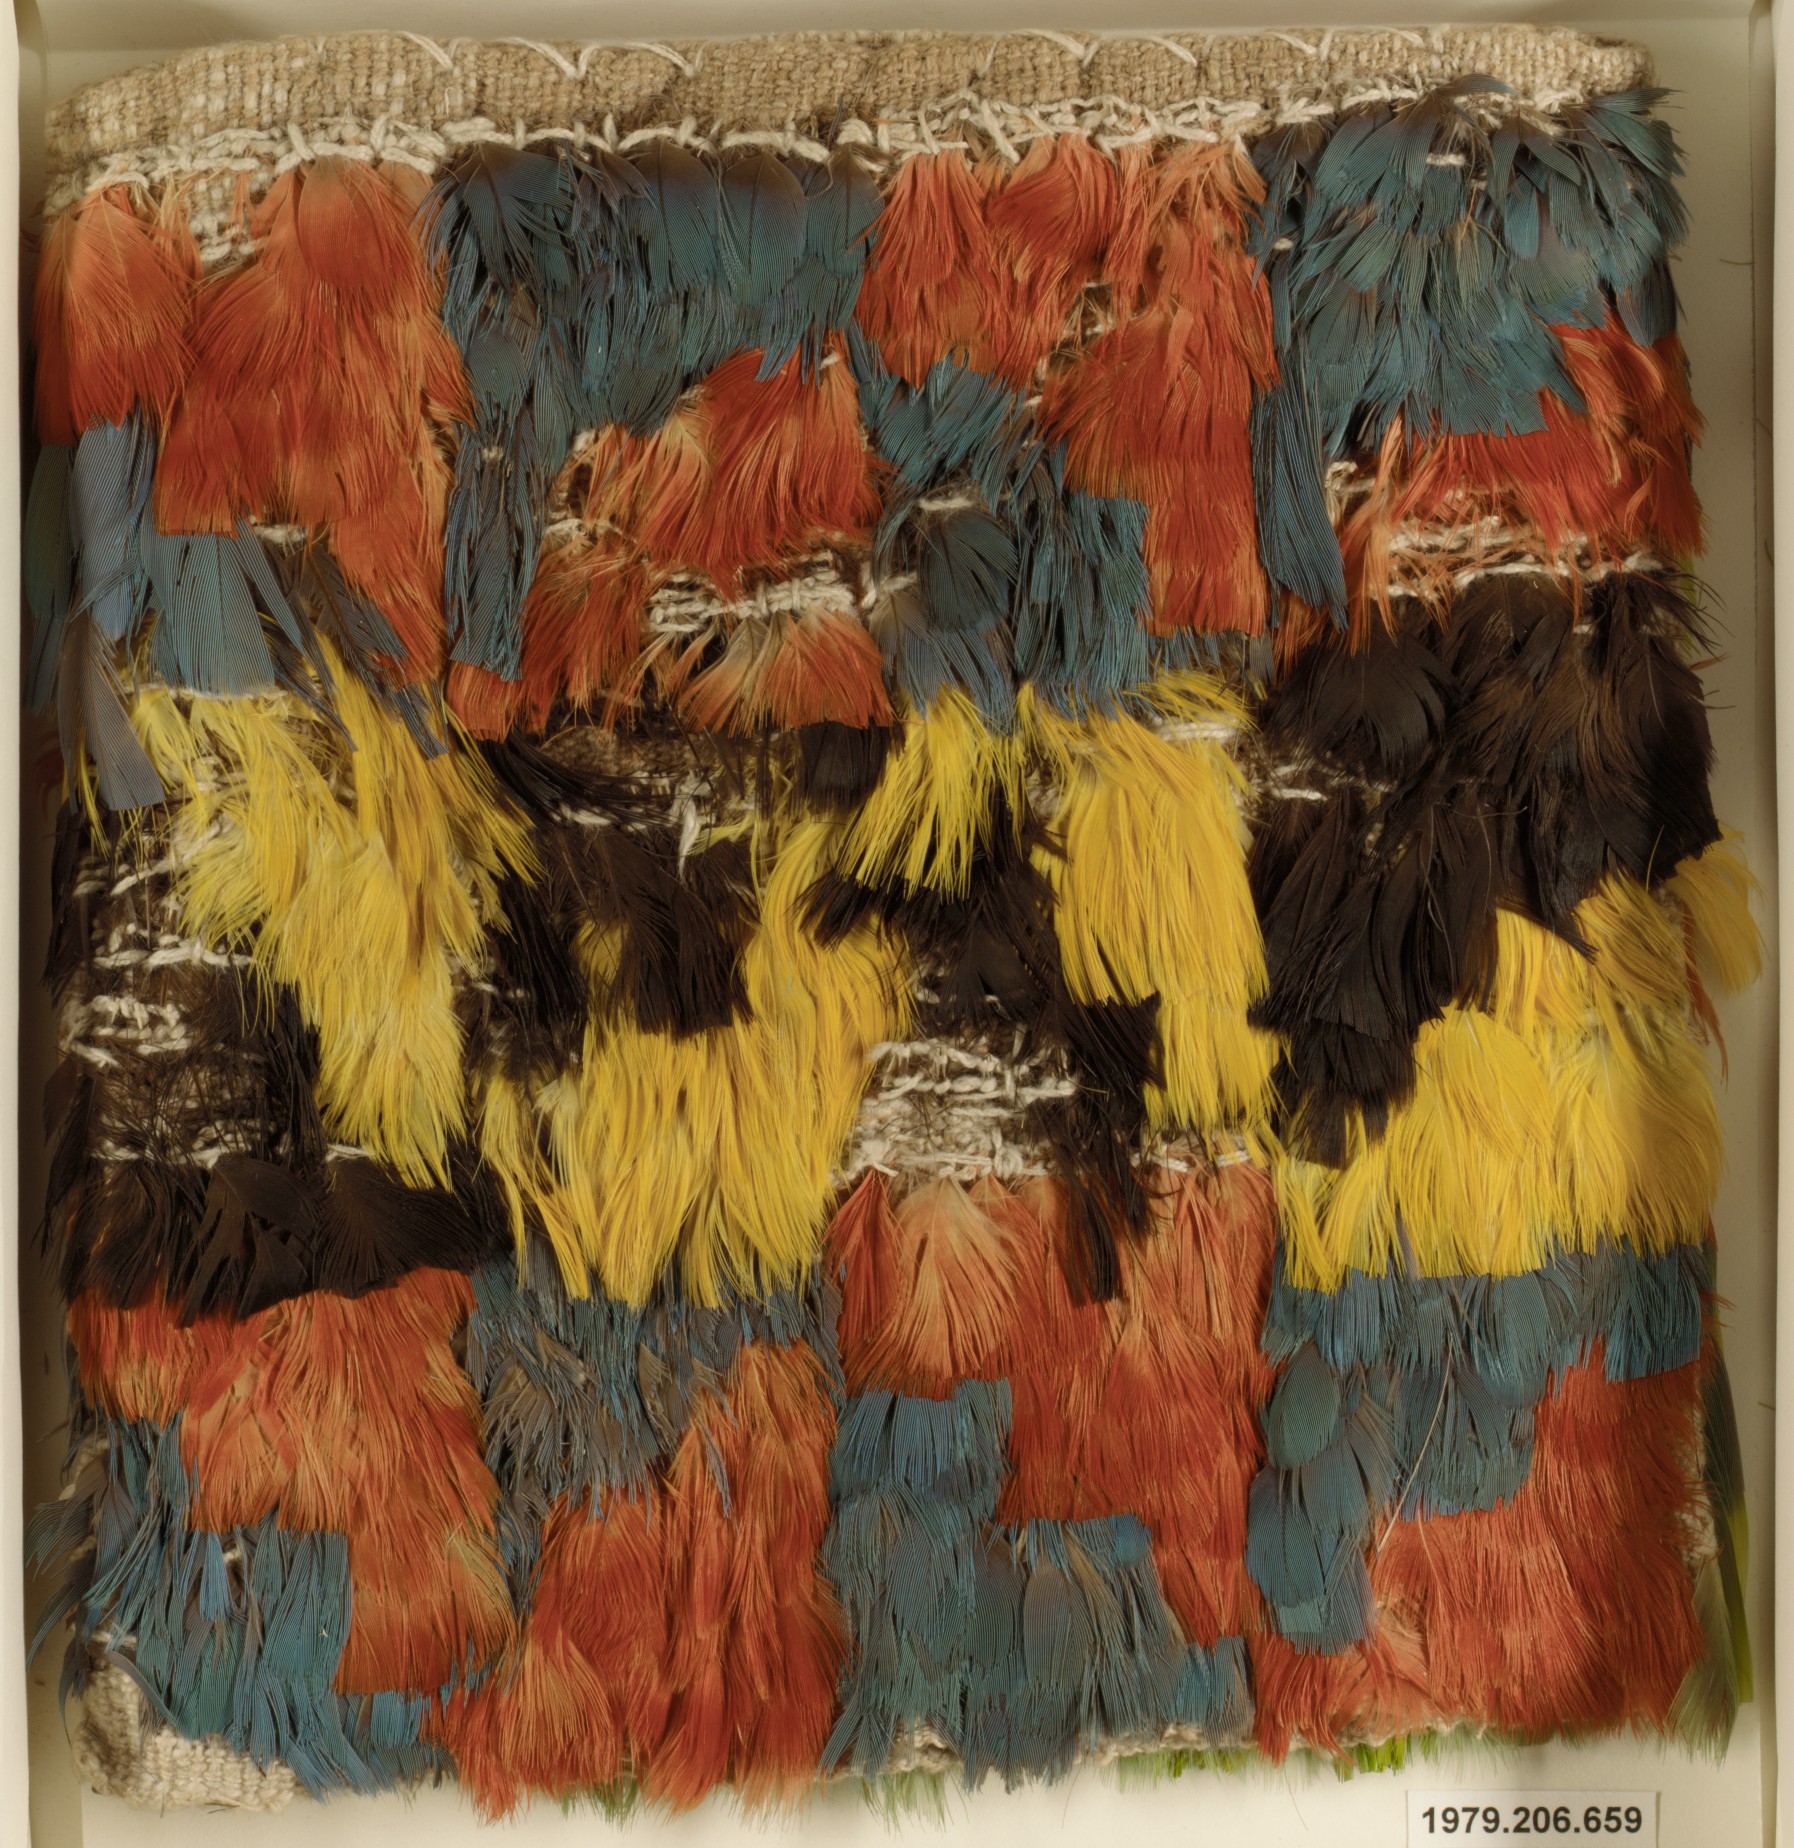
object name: miniature dress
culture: ica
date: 1101-1300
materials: cotton, feather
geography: peru